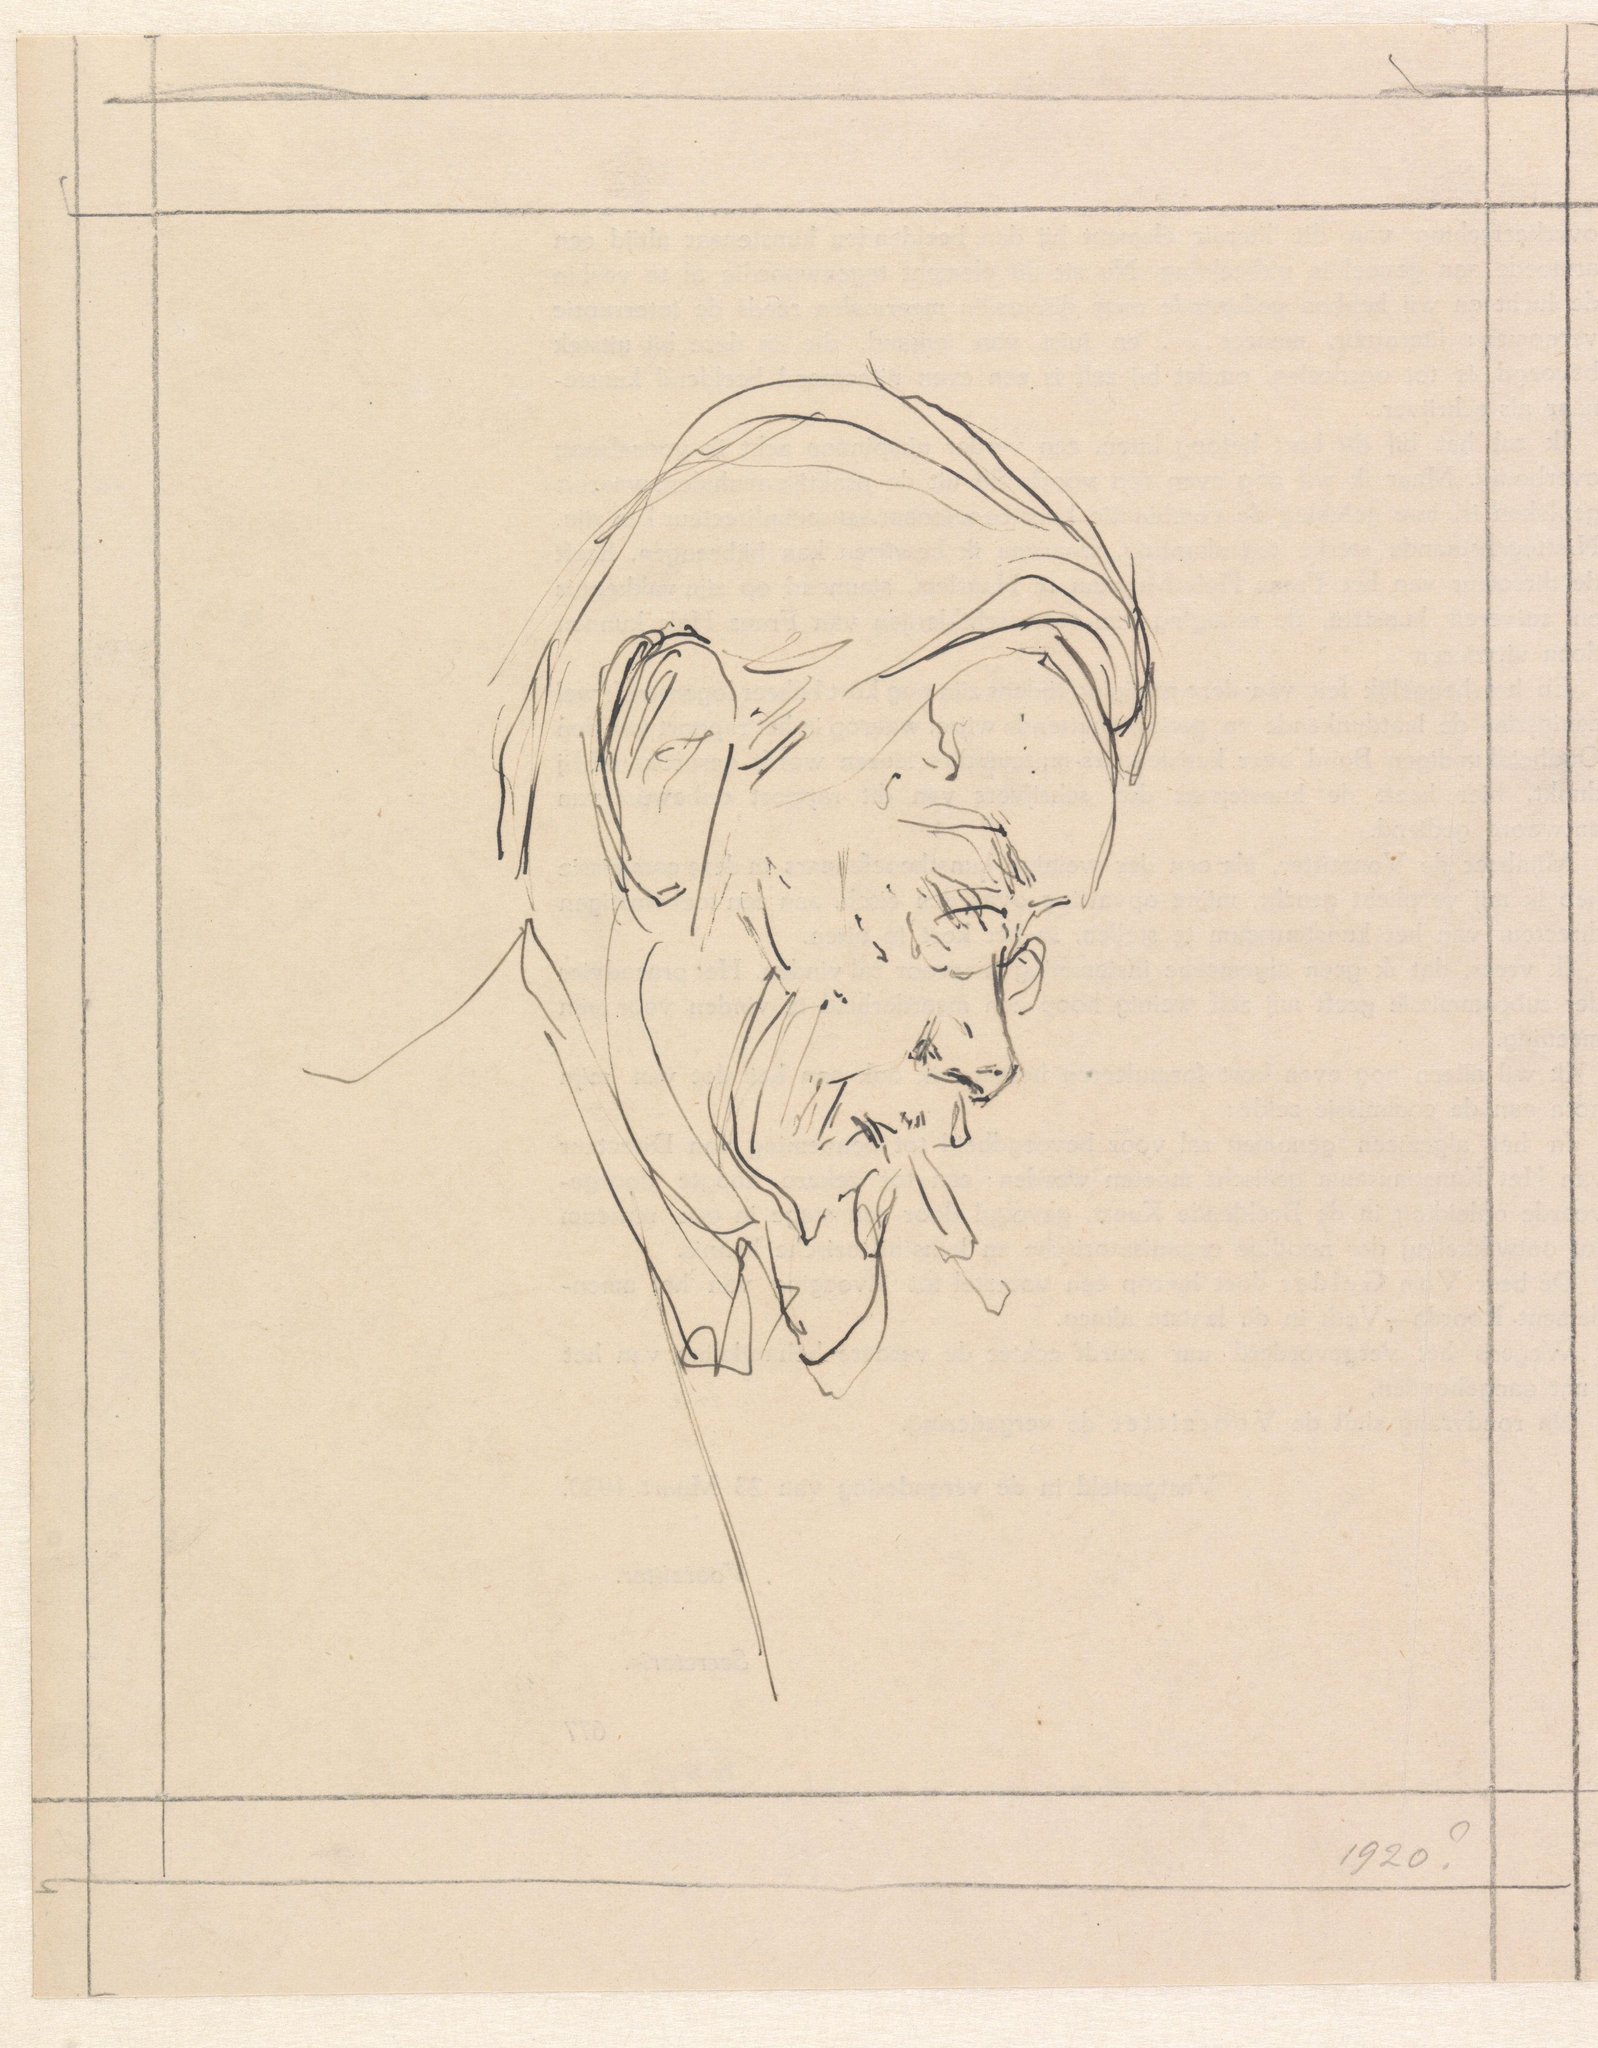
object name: drawing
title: Portret van Cornelis Hofstede de Groot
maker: jan veth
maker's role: designer, draughtsman, painter, print maker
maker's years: 1864-1925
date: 1874-1925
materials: ink, paper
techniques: pen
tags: the hague, cornelis hofstede de groot, historical persons